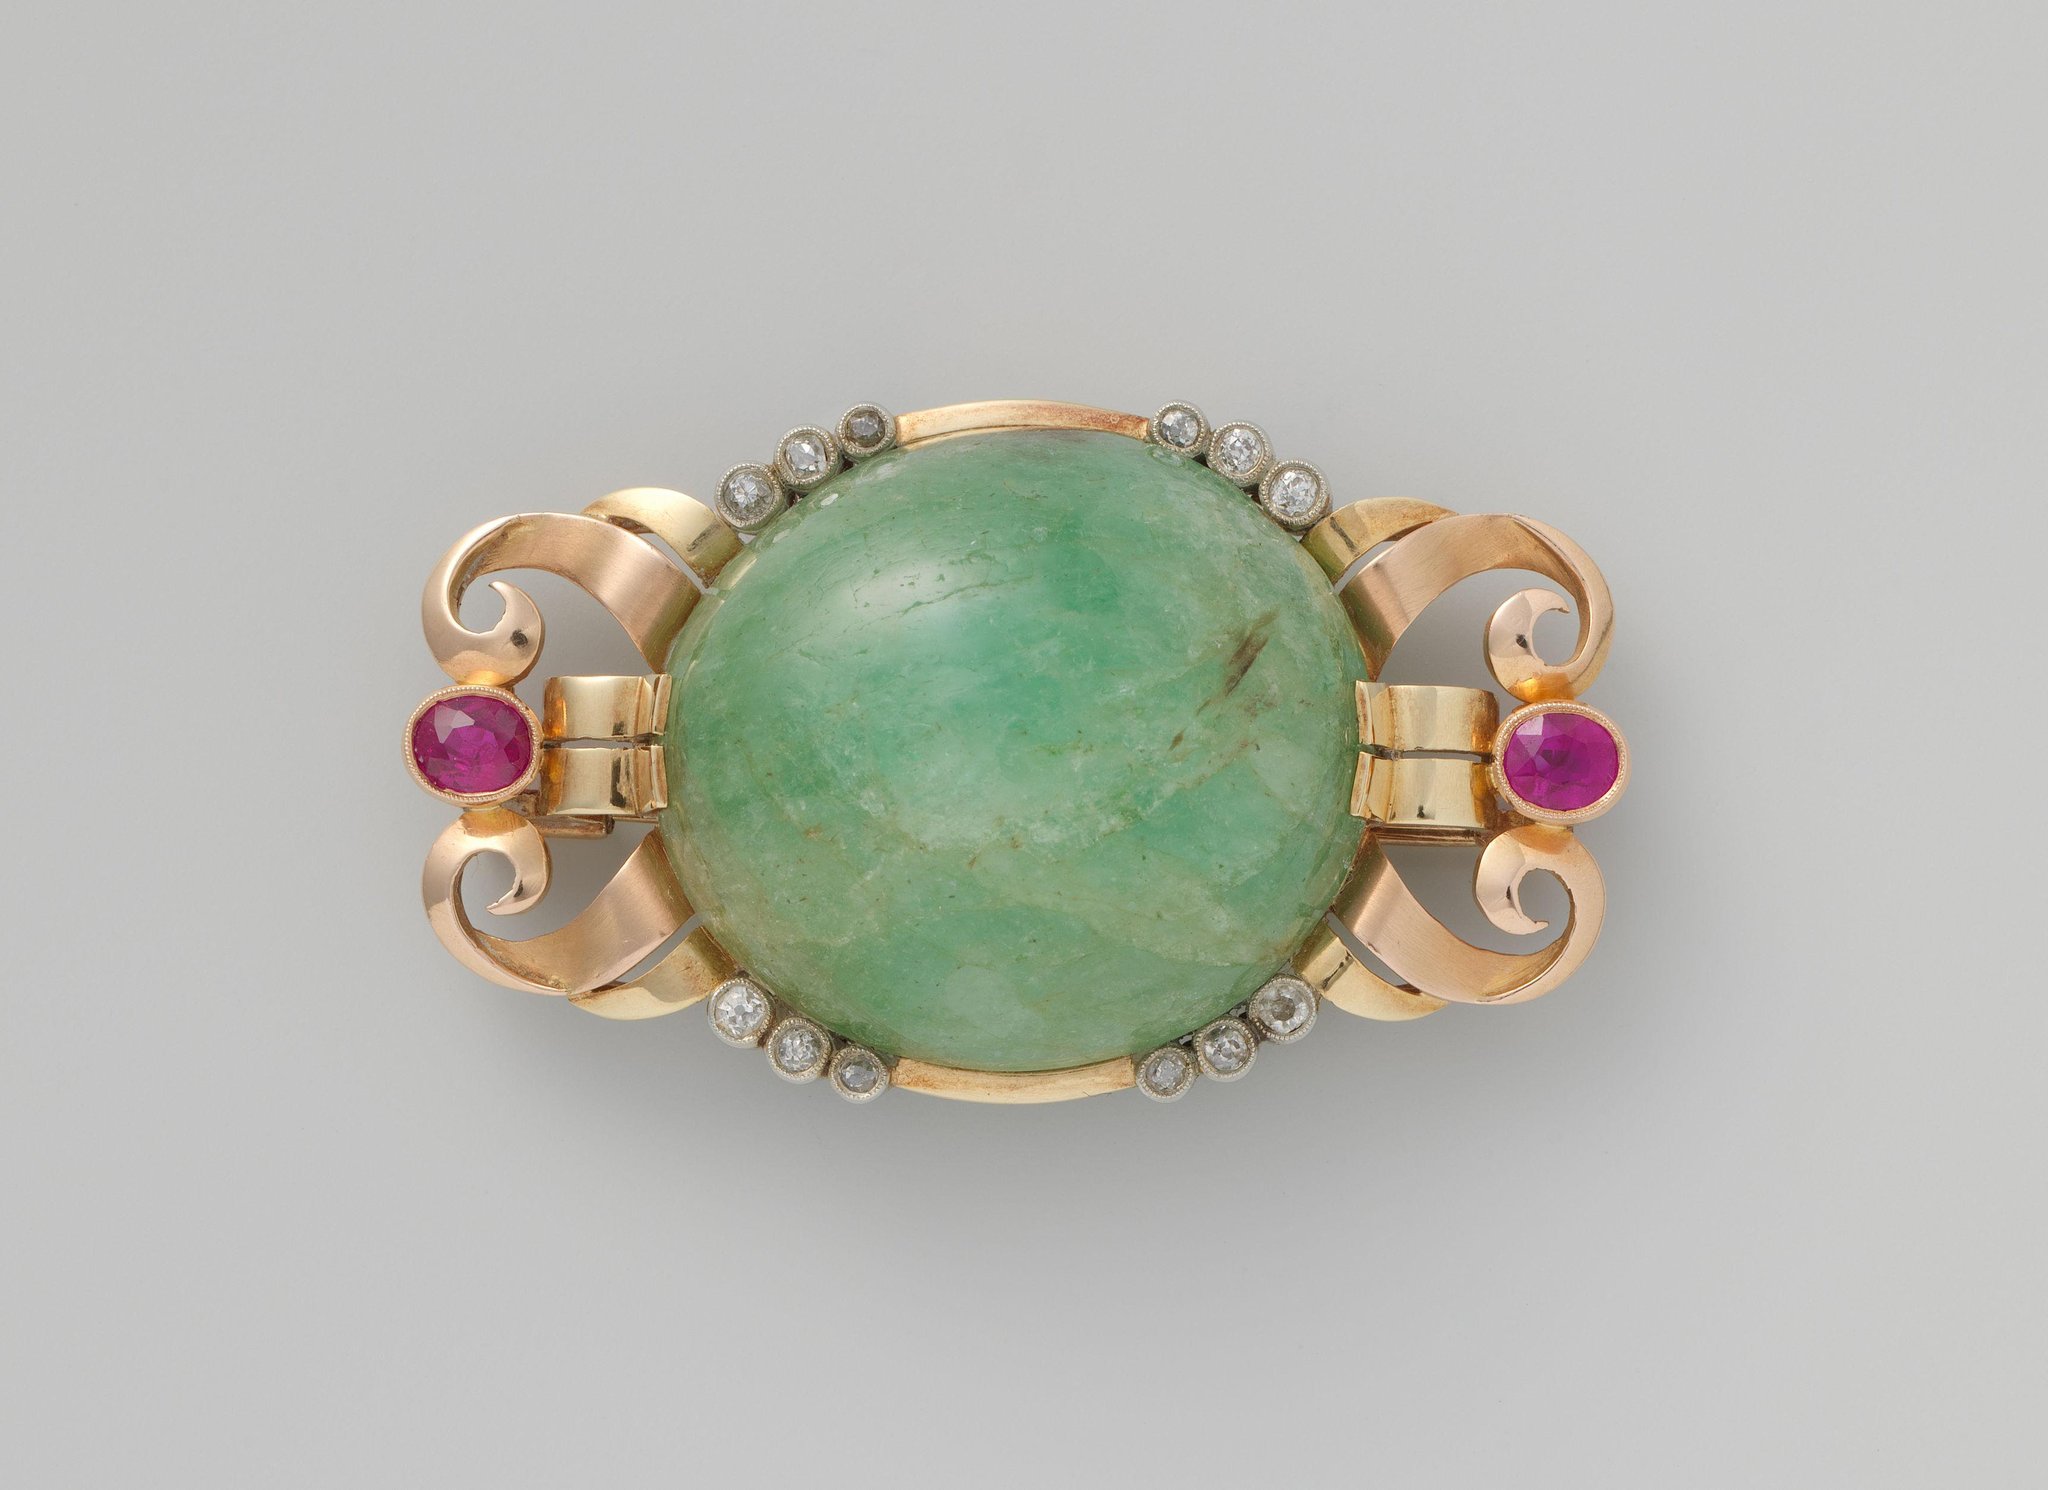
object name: brooch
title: Broche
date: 1945-1953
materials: gemstone, diamond, gold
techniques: faceting, granulation, grinding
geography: the hague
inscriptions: alloy mark: ‘(oud) eikenblad’, maker's mark: ‘V.Z.K.’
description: Broche van roodgoud met groene beryl, robijnen en diamanten. De ovale beryl is cabochon geslepen en wordt omringd door vier keer drie gefacetteerde diamanten op rij voorzien van een kanonsluiting. Aan weerszijden van de ovaal gevat tussen gouden krullen in een gegranuleerde rand zit een robijn.